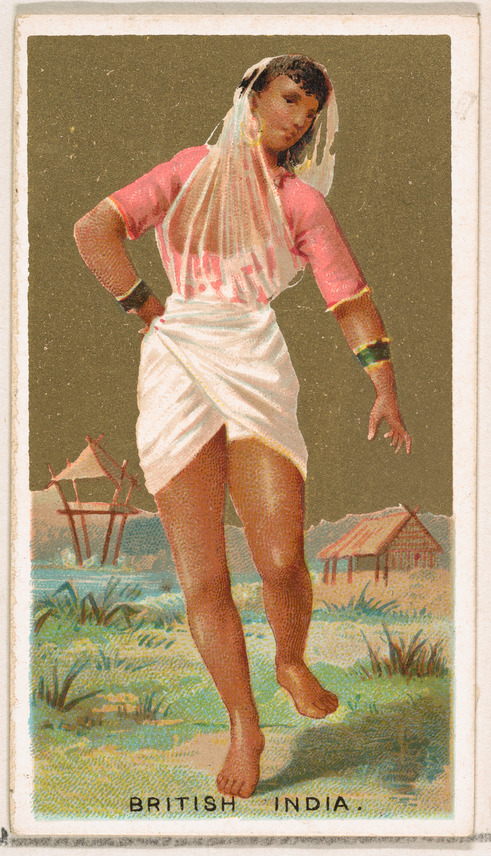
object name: print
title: British India, from the Dancing Girls of the World series (N185) issued by Wm. S. Kimball & Co.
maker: william s. kimball & company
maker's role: publisher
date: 1889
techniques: color lithograph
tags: dance,girls,dancers